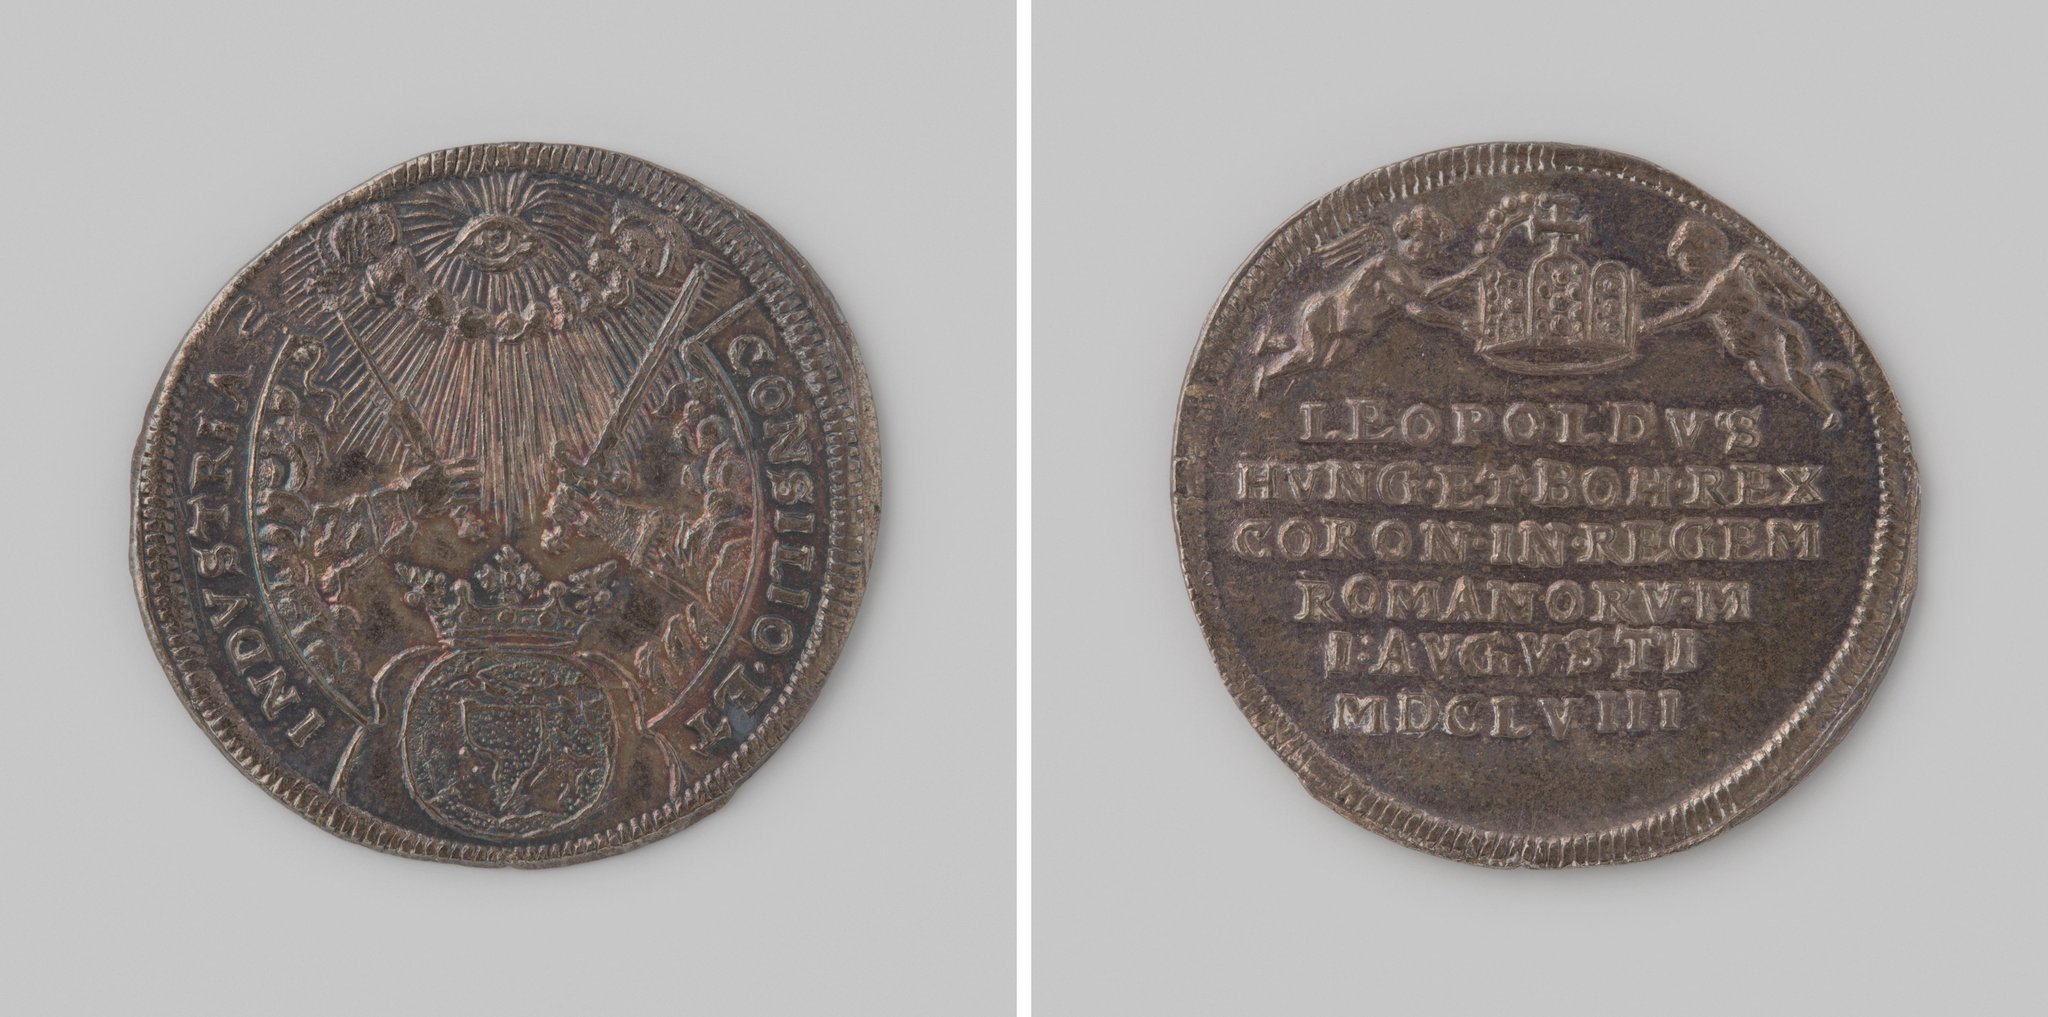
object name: history medal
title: Kroning van Leopold I tot keizer van Duitsland 1658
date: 1658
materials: silver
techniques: striking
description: Zilveren penning, op de voorzijde twee armen met zwaarden uit de wolken onder een stralend oog Gods, onderaan een gekroond medaillon, met omschrift, op de keerzijde twee zwevende engelen met een kroon waaronder zes regels tekst.